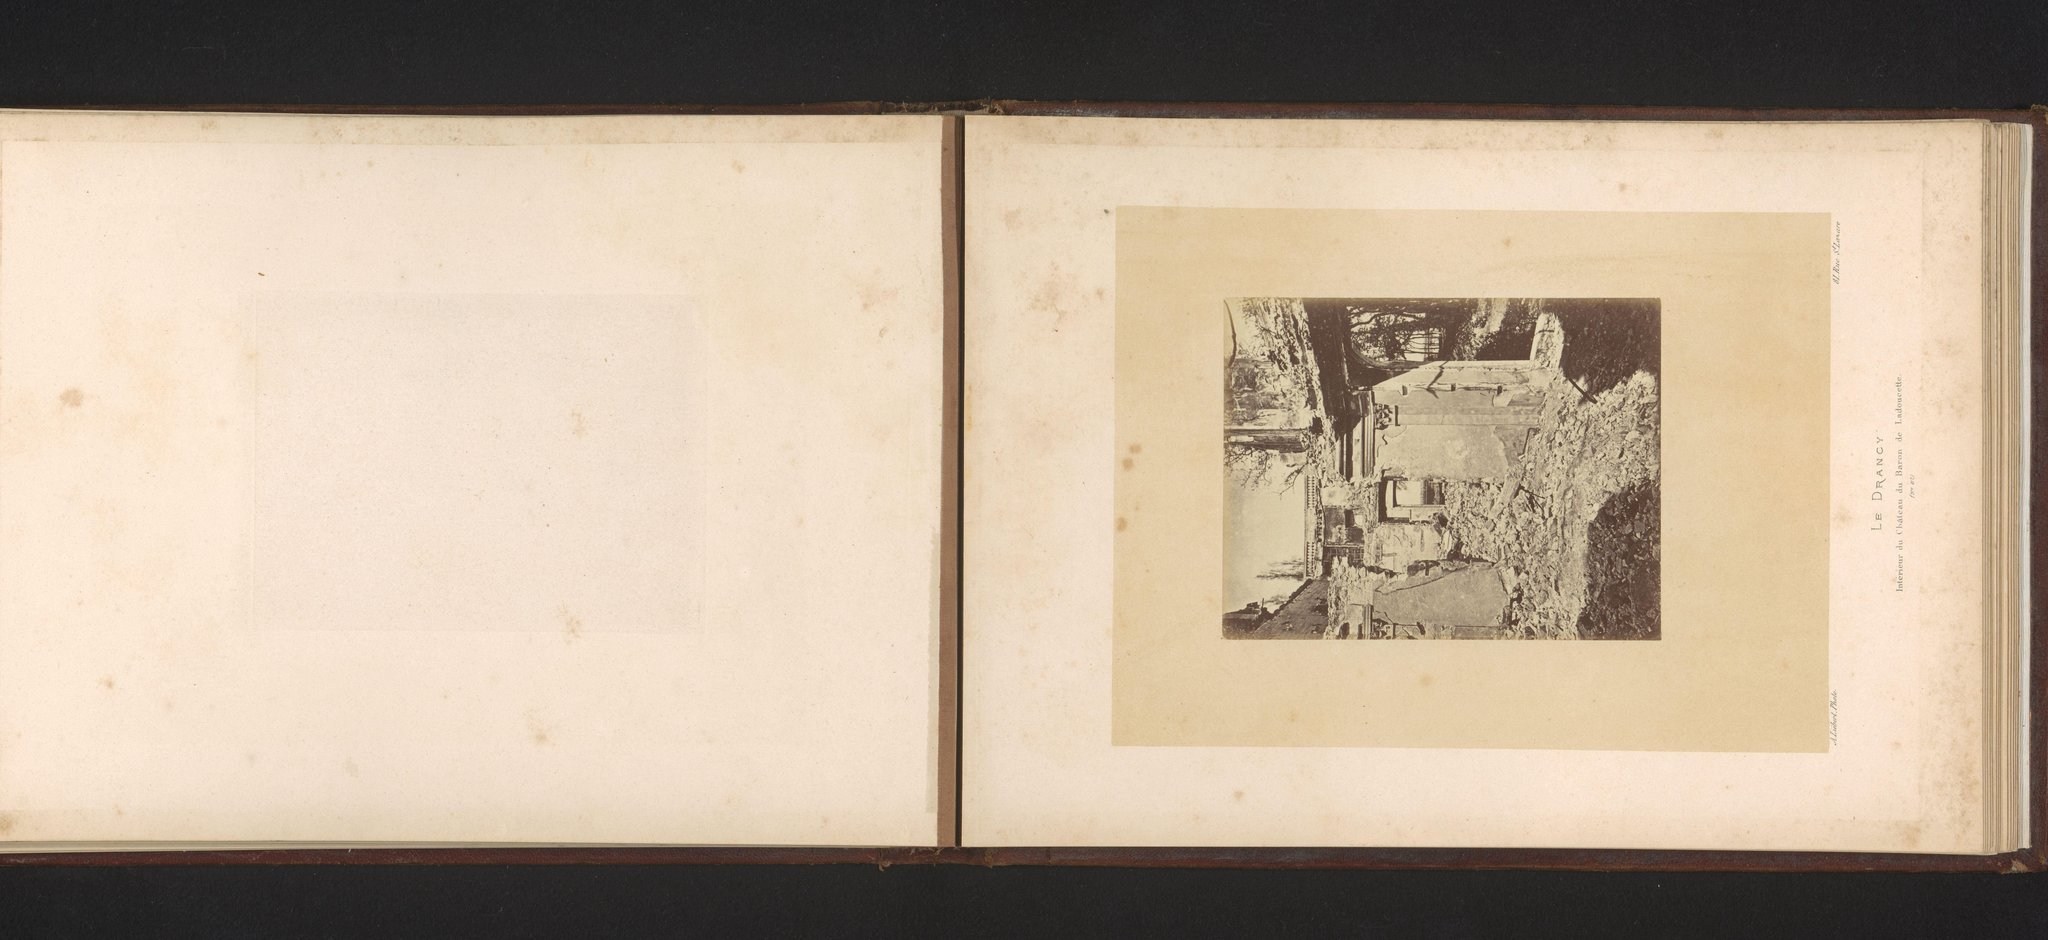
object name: page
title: Gezicht op het interieur van de villa van Baron de Ladoucette in Drancy na de verwoesting door de Commune van Parijs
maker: alphonse-justin liébert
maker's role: fotograaf, marinier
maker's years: 1827-1914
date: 1871-1872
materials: photographic support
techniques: albumen print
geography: drancy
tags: ruin of a building ~ architecture, villa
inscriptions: address: ‘31, Rue St. Lazare’, number: ‘(No. 87)’